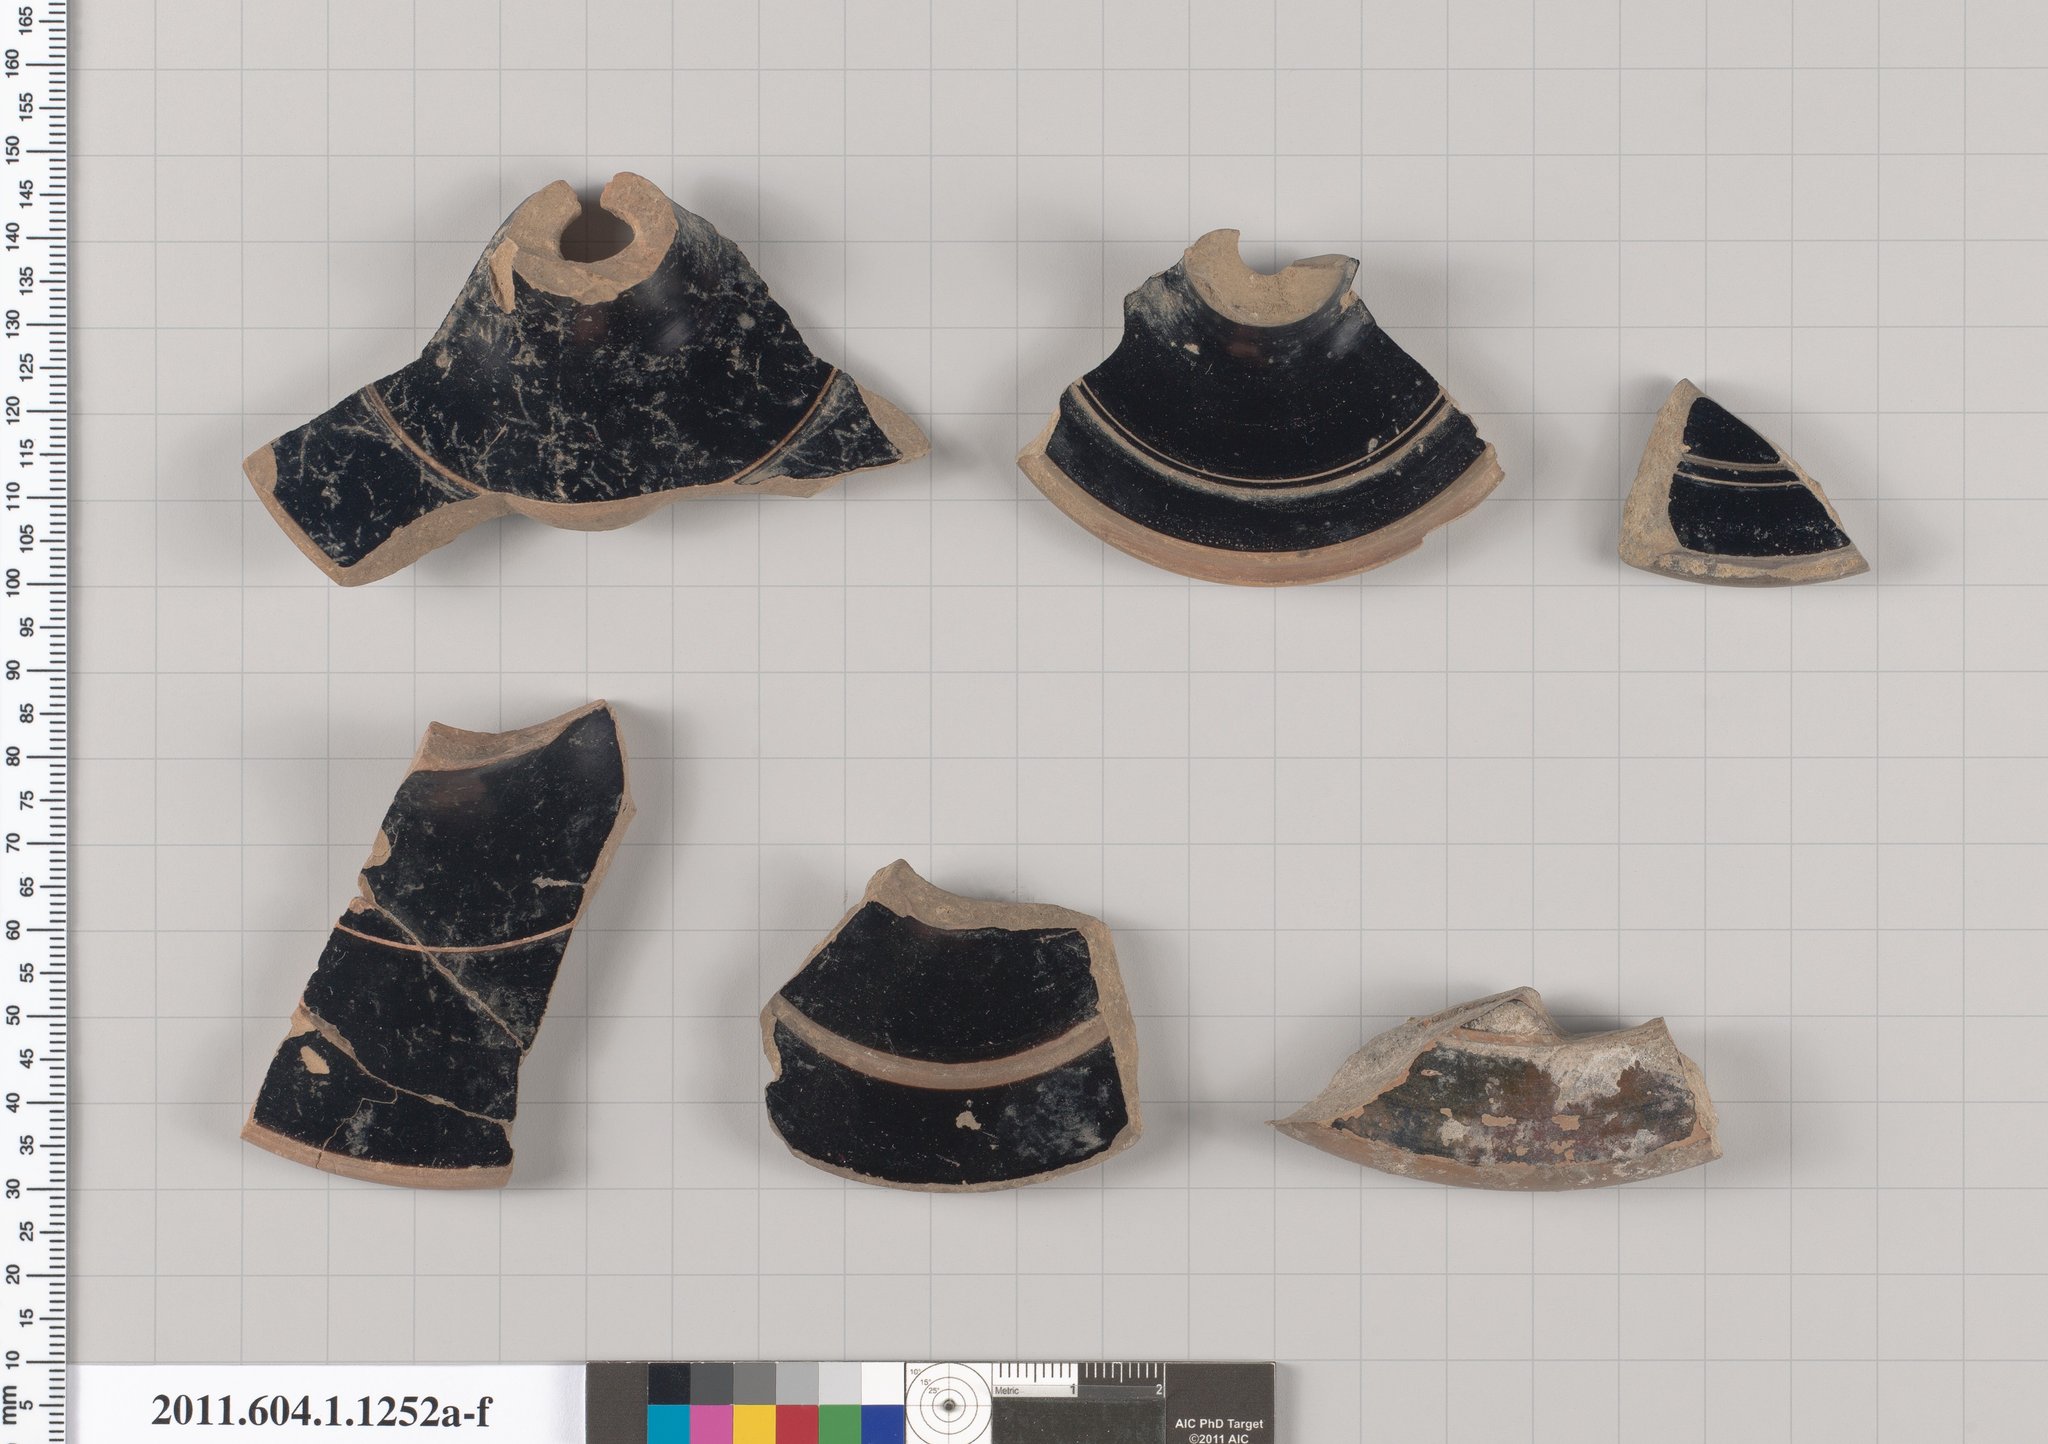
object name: kylix fragment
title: Terracotta fragments of kylikes (drinking cups)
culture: greek, attic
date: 500-401 BCE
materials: terracotta